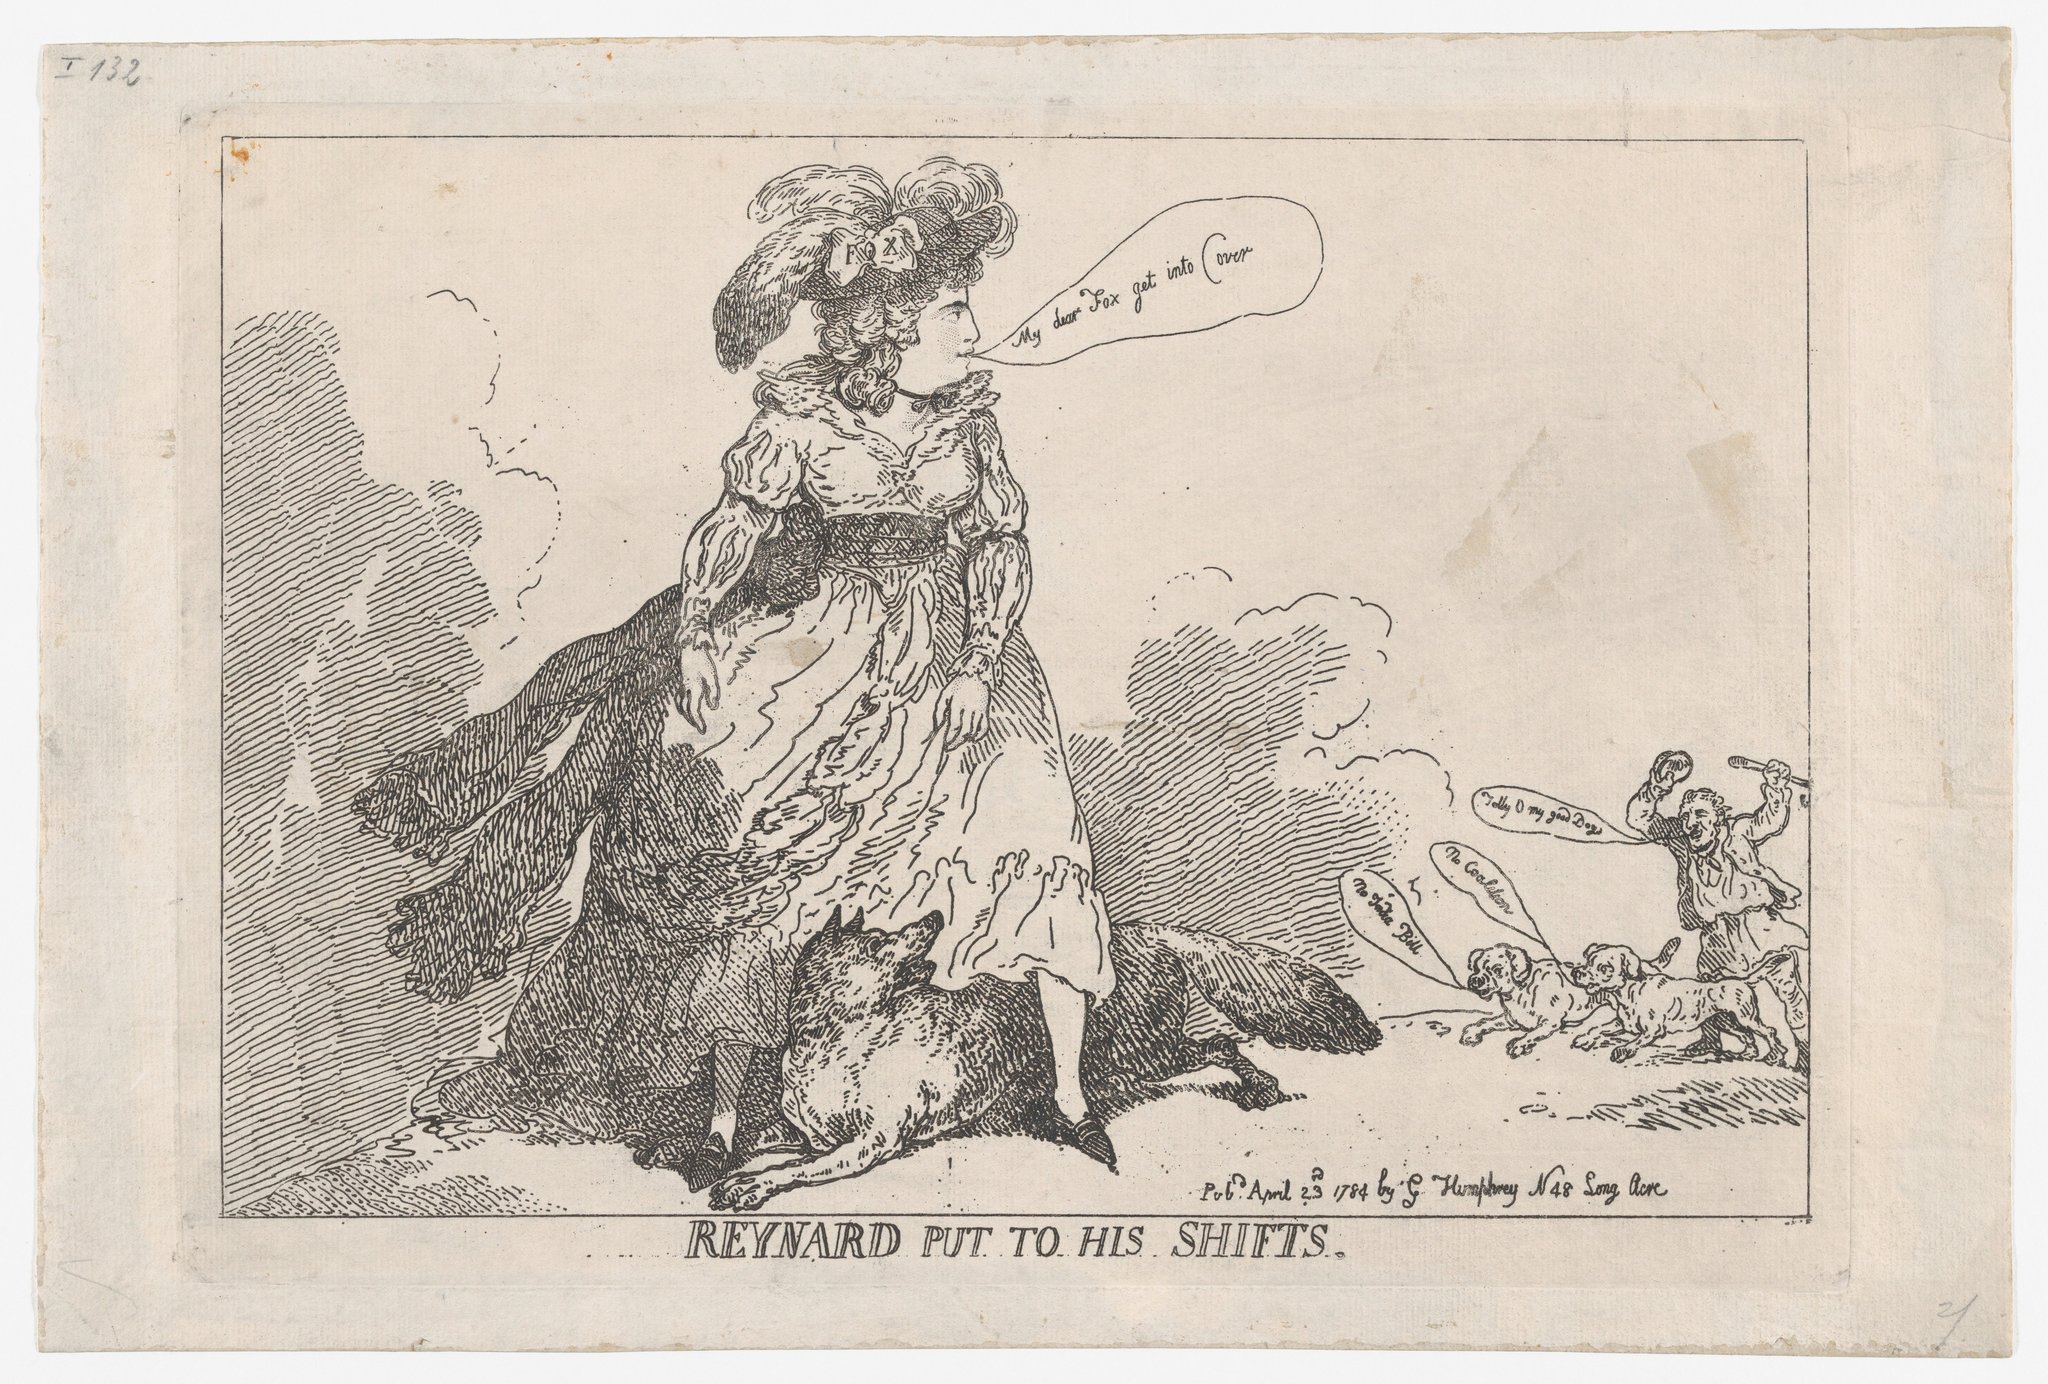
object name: print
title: Reynard Put To His Shifts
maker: thomas rowlandson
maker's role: artist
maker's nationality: british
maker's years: 1757-1827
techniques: etching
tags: animals,satire,men,women,foxes